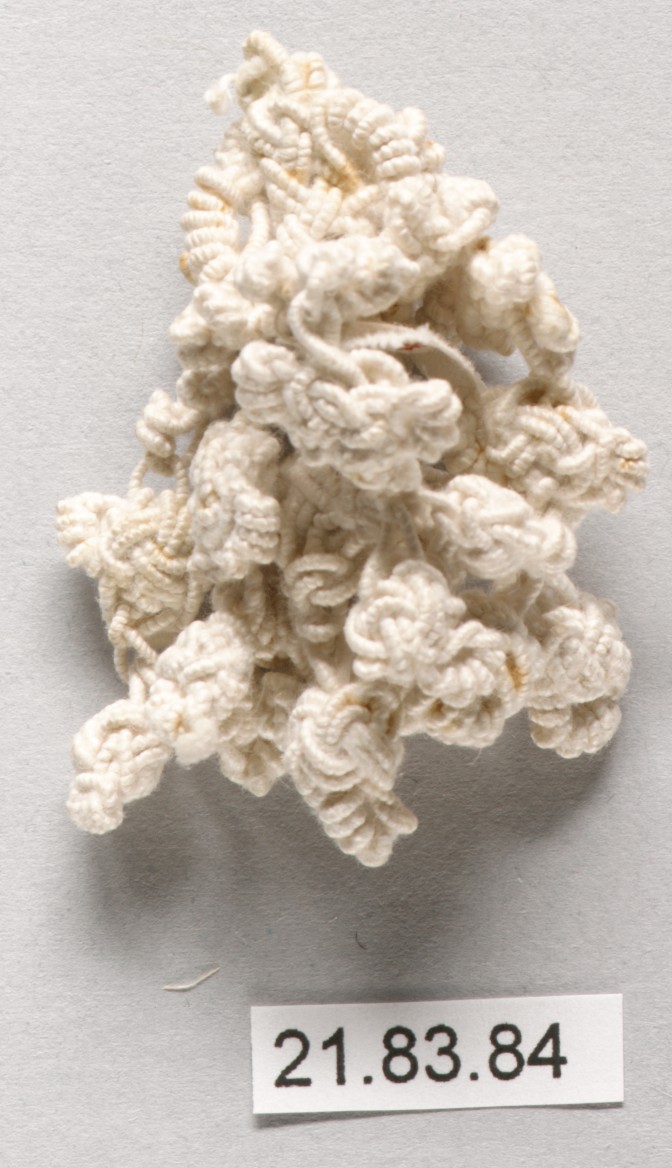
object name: tassel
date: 1601-1700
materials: linen